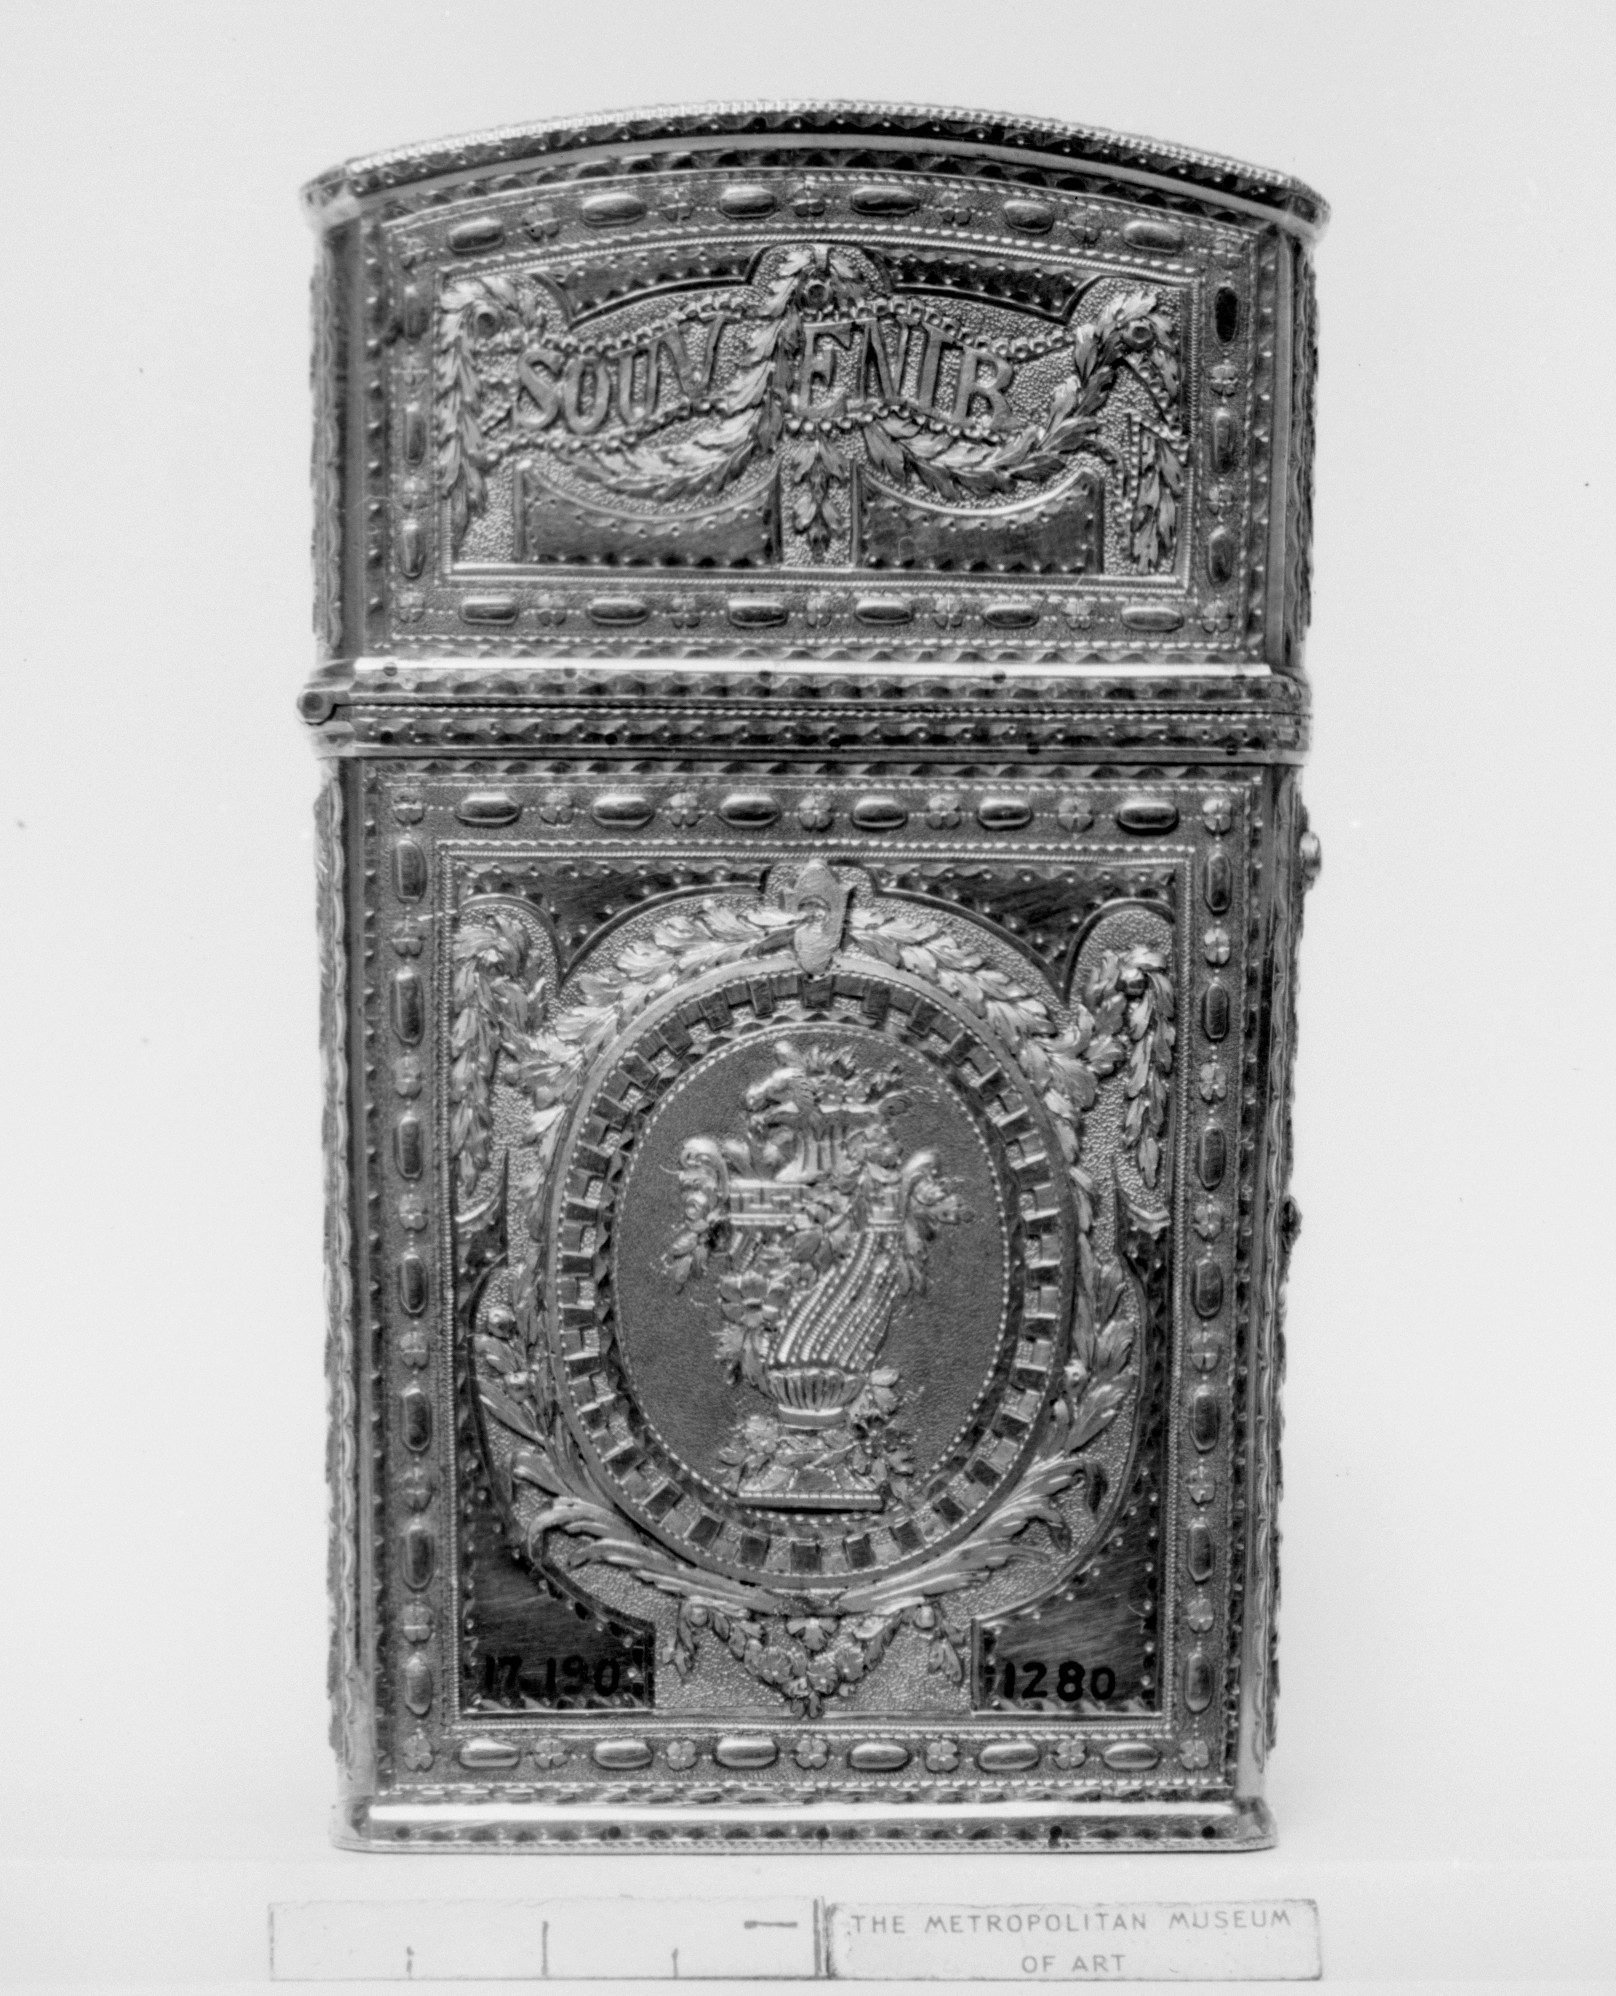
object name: souvenir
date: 1776-1800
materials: gold, ivory